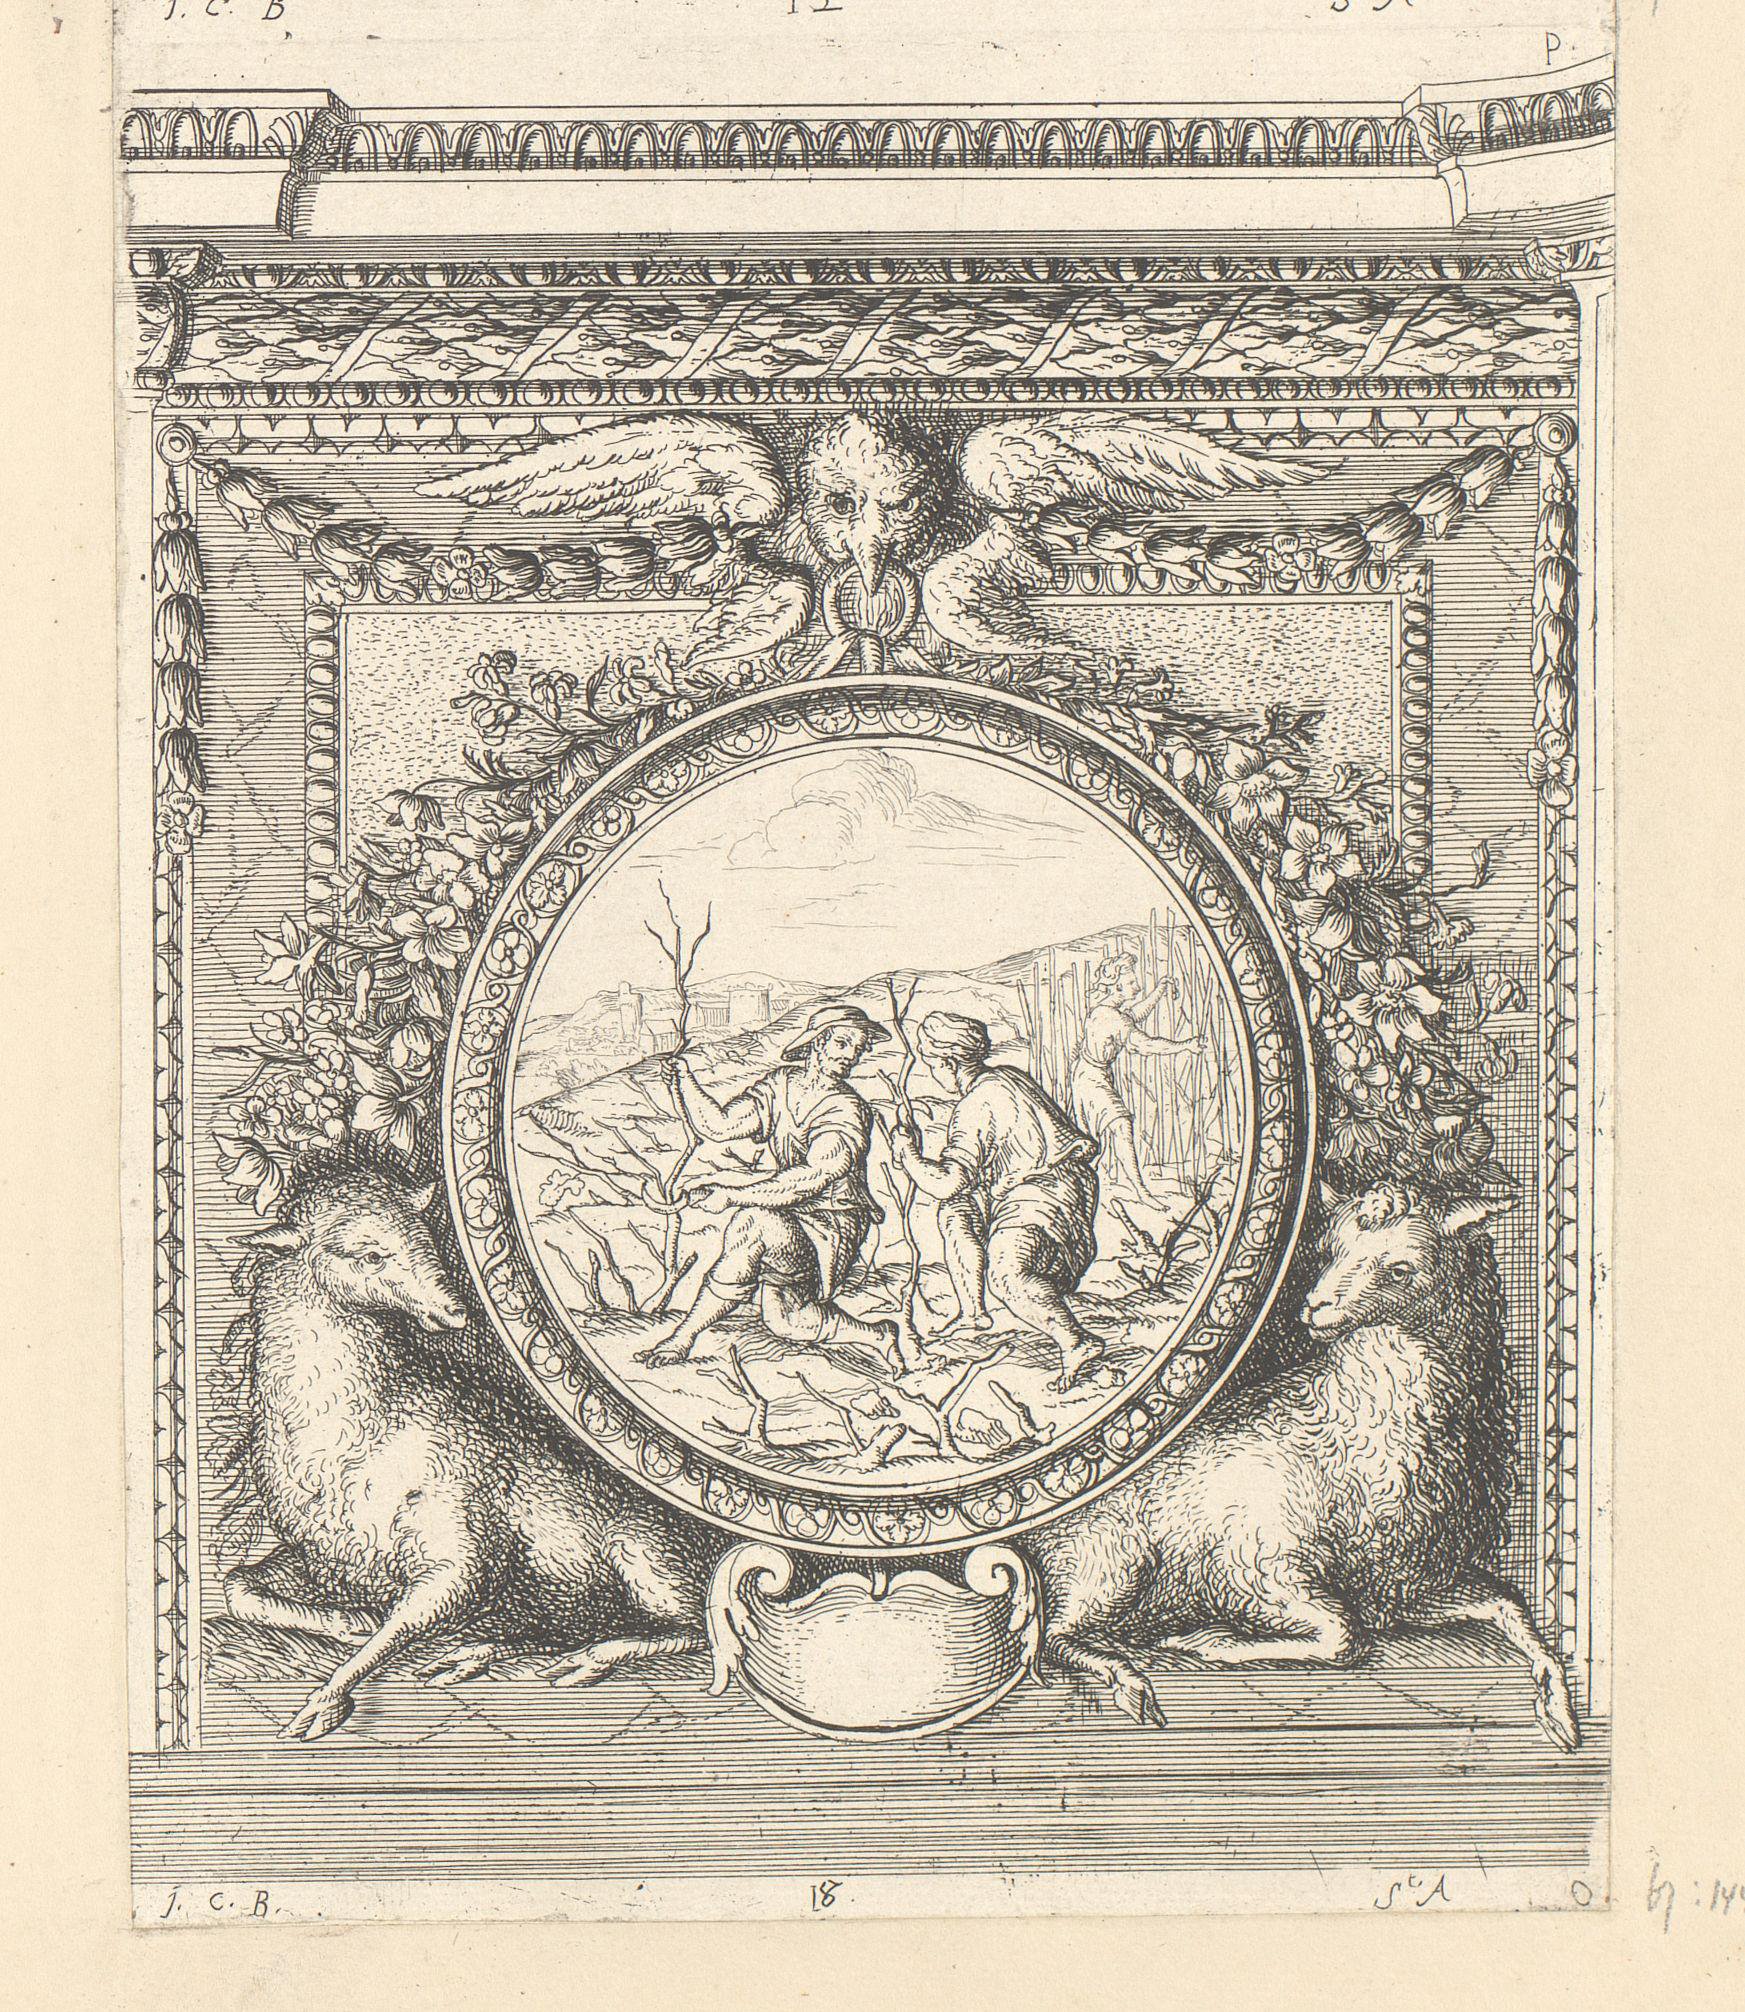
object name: album leaf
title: Kleine galerie van het Louvre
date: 1695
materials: paper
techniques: etching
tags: cultivation of (ornamental) garden, ornaments ~ art, march and its 'labours', sheep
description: Een schaap aan weerszijden van een medaillon met daarop twee in het veld werkende mannen. Deze prent maakt deel uit van een album.